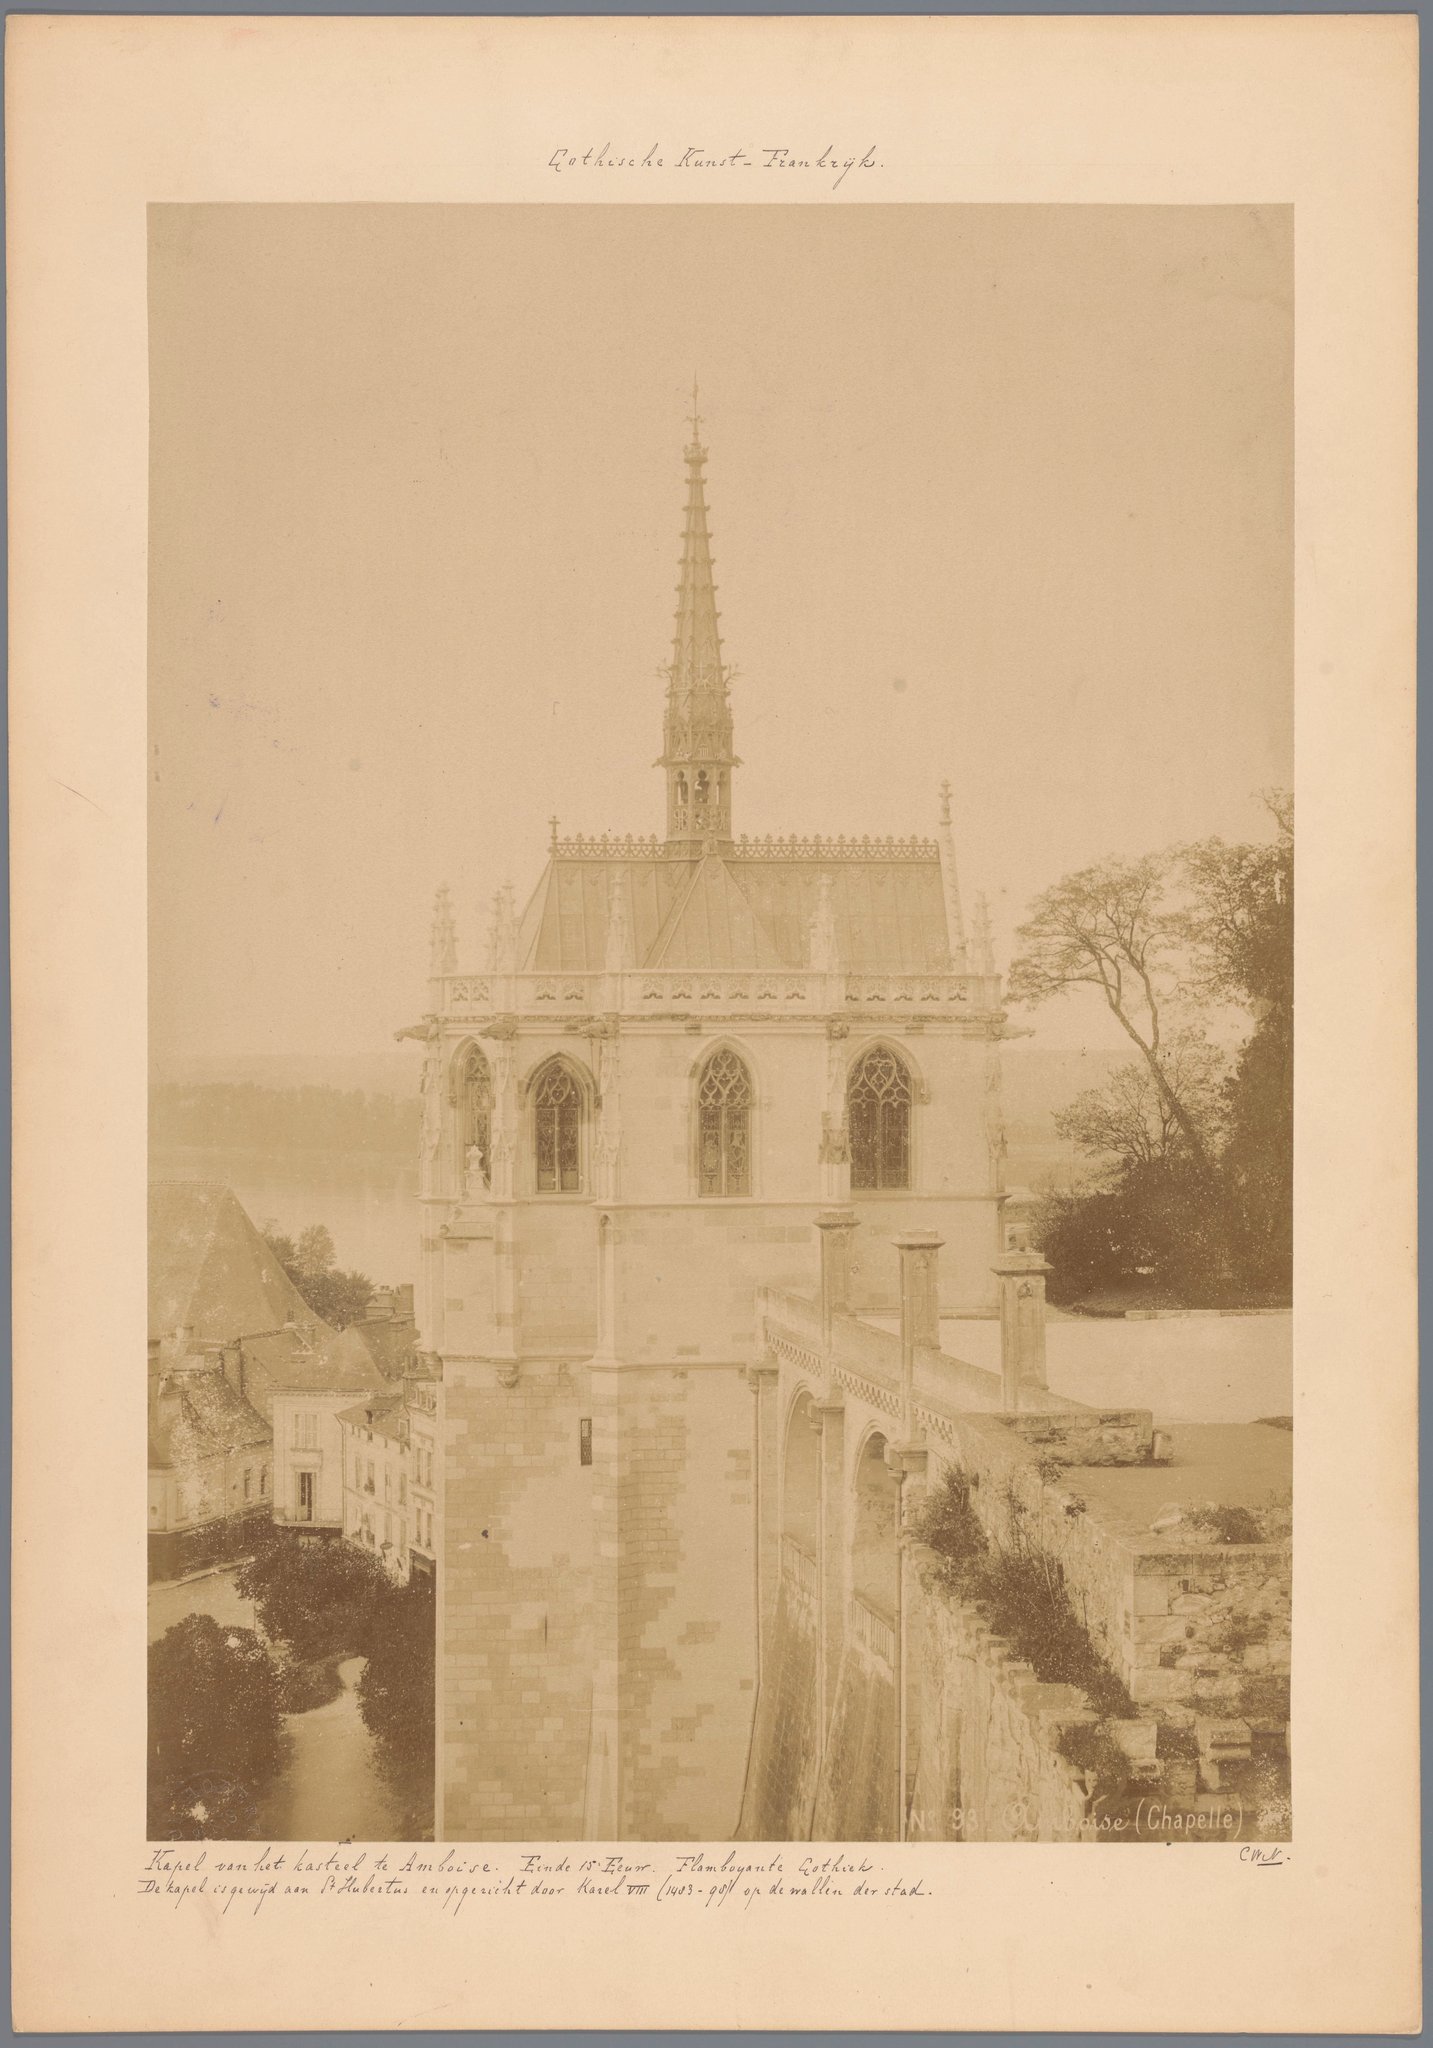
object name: photograph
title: Amboise (Chapelle)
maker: paul robert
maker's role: fotograaf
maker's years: 1865-1905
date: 1875-1900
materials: cardboard, photographic support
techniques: albumen print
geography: amboise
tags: walls ~ fortified city, church (exterior) - qq - small church, chapel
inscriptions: inscription: ‘Gothische Kunst - Frankrijk.’, collector's mark: ‘KUNSTNIJVERHEIDSCHOOL QUELLINUS AMSTERDAM FRANS HALSSTRAAT 14.’, collector's mark: ‘INSTITUUT VOOR KUNST-NIJVERHEIDSONDERWIJS GABRIËL METSUSTRAAT No. 16 AMSTERDAM’, inscription: ‘CWN.’, name: ‘PAUL ROBERT PARIS’, number: ‘No. 93.’